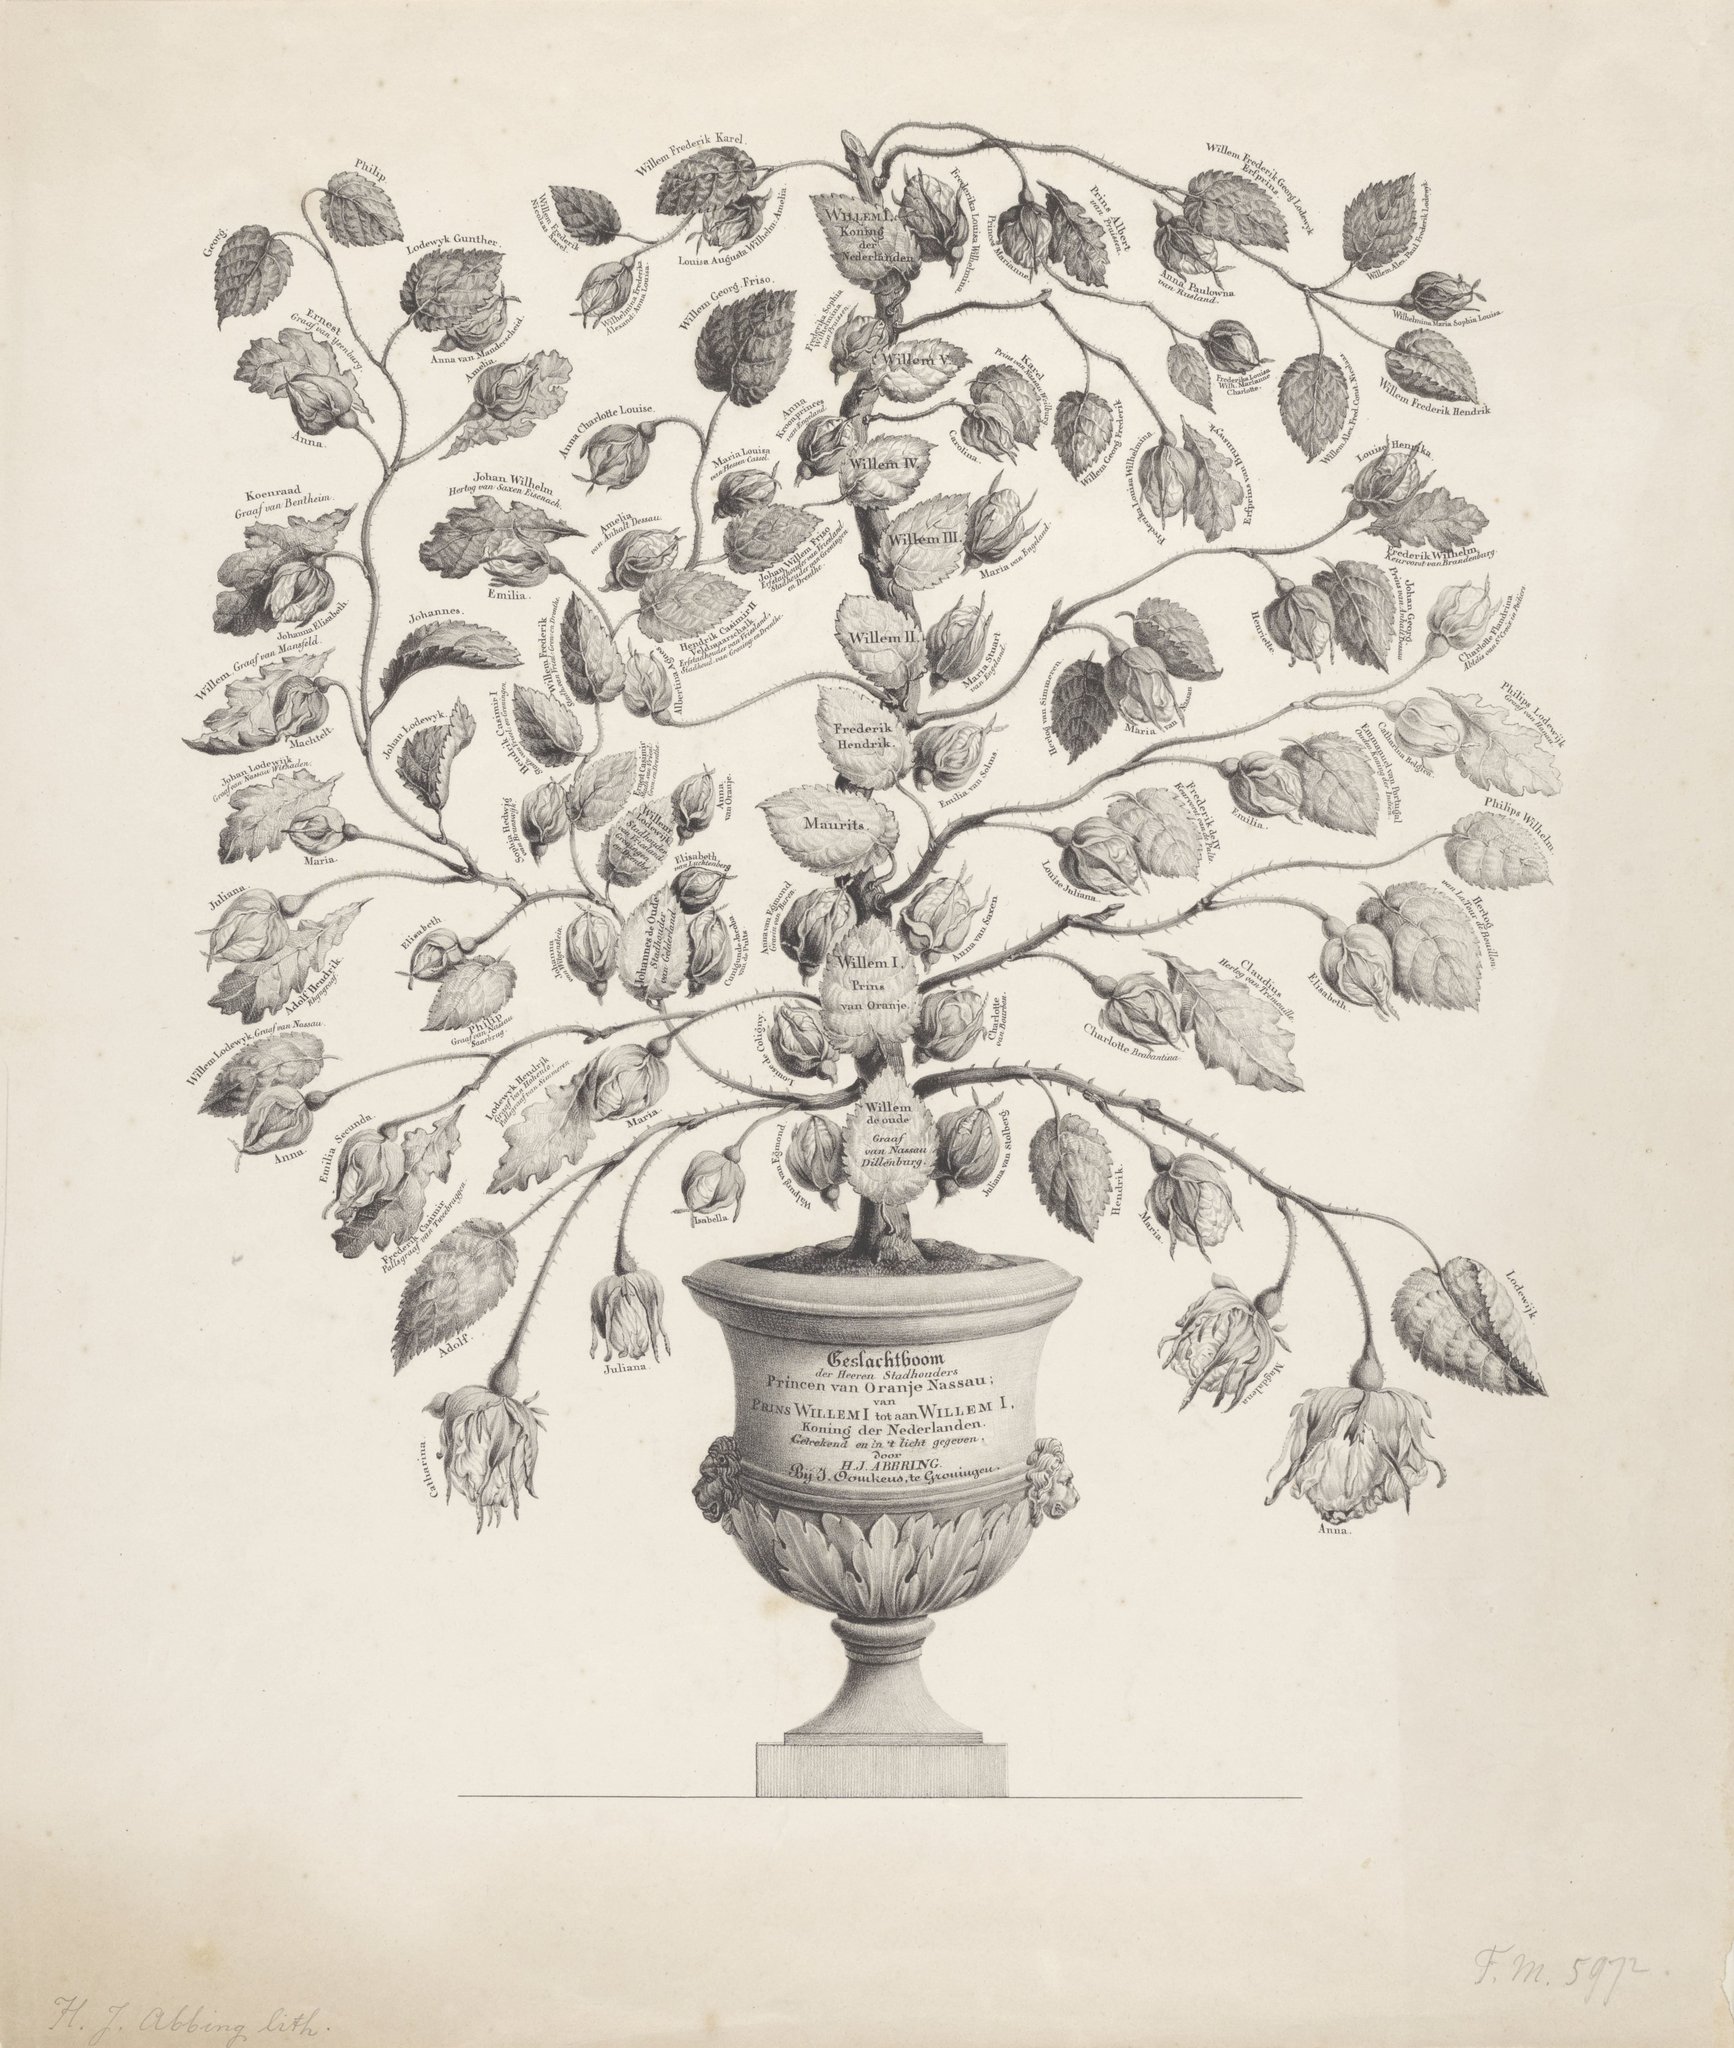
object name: print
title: Stamboom van het Huis Oranje-Nassau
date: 1813-1844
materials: paper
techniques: lithograph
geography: groningen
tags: william v (prince of orange), johan willem friso (prins van oranje-nassau), louise de coligny, william i of the netherlands, antwerp, charlotte of bourbon, william iii (prince of orange and king of england, scotland, and ireland), delft, frederick henry (prince of orange), william ii (prince of orange), william i (prince of orange), maurice (prince of orange), london, maria ii stuart (koningin van engeland, schotland en ierland), amalia of solms-braunfels, mary henrietta stuart, berlin, painter, draughtsman, wilhelmina of prussia (princess of orange), grave, willem iv (prins van oranje-nassau), anna van hannover, the hague, wilhelmina frederica louisa (koningin der nederlanden), family lineage, pedigree, genealogical tree or table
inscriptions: inscription: ‘H.J. Abbing lith’, collector's mark: Lugt 2228a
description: Stamboom van het Huis Oranje-Nassau, van Willem I tot en met Willem I Frederik. Aan de takken van een boom bladeren en knoppen met namen en titels. Op de pot zes regels Nederlandse tekst.